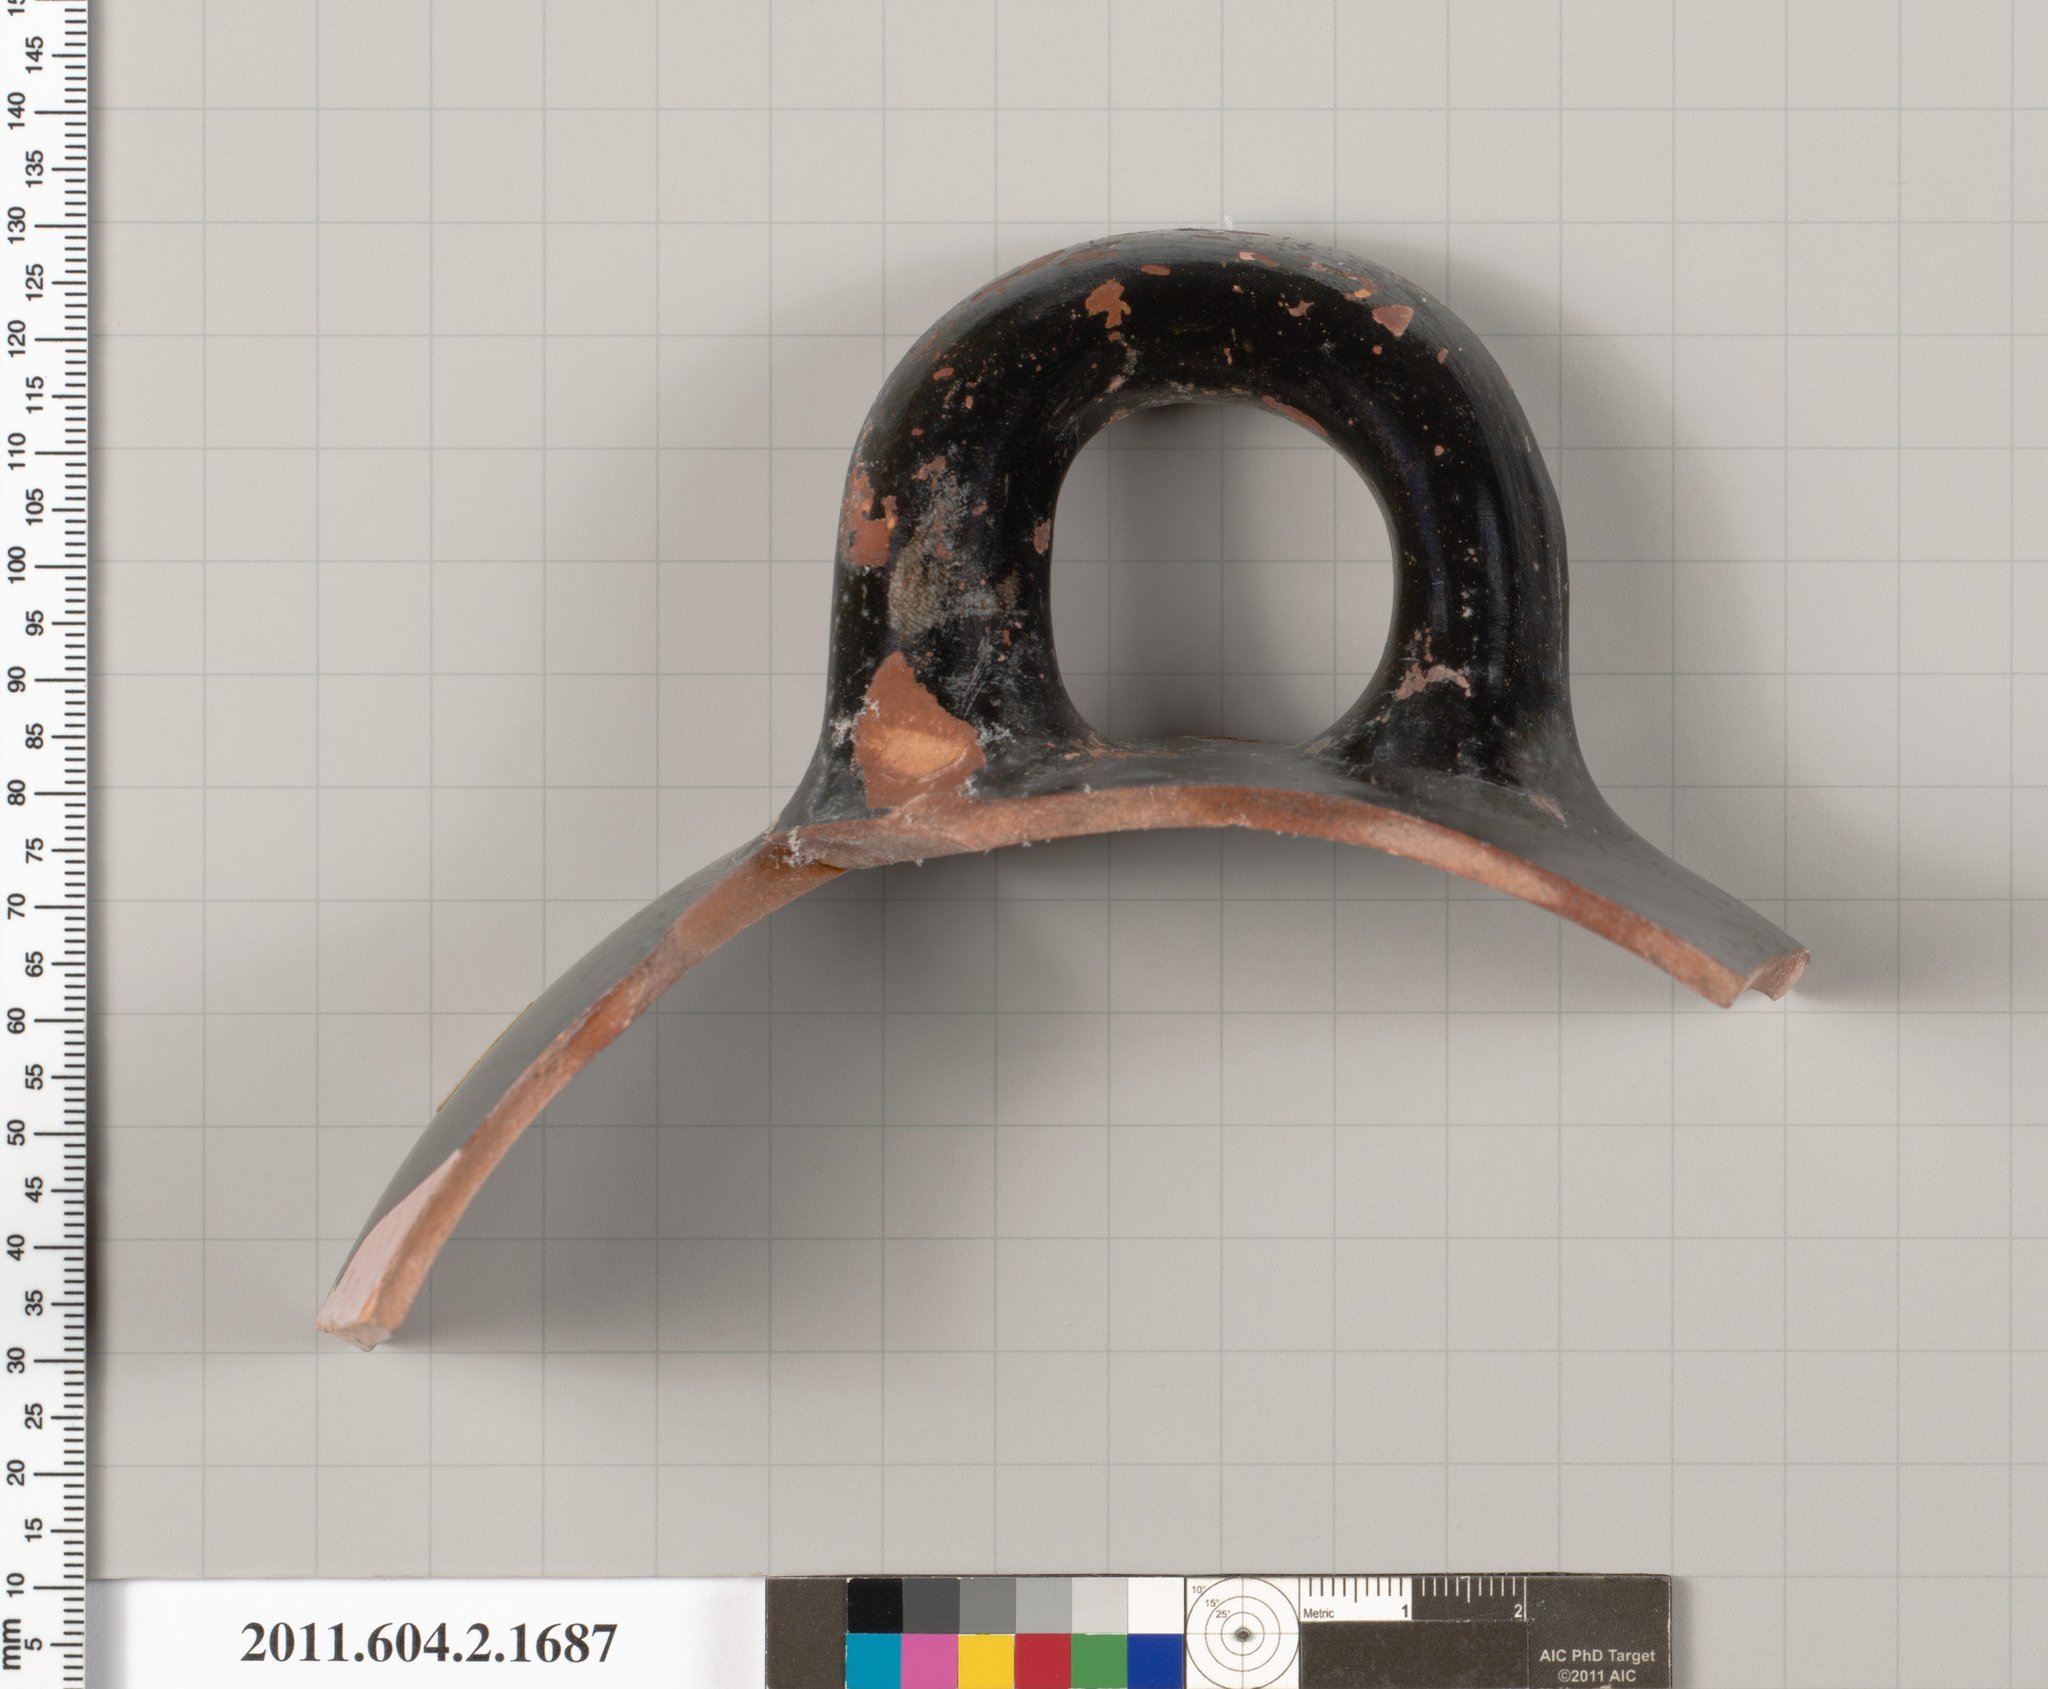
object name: skyphos fragment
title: Terracotta fragment of a skyphos (deep drinking cup)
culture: greek, attic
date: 460-450 BCE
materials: terracotta